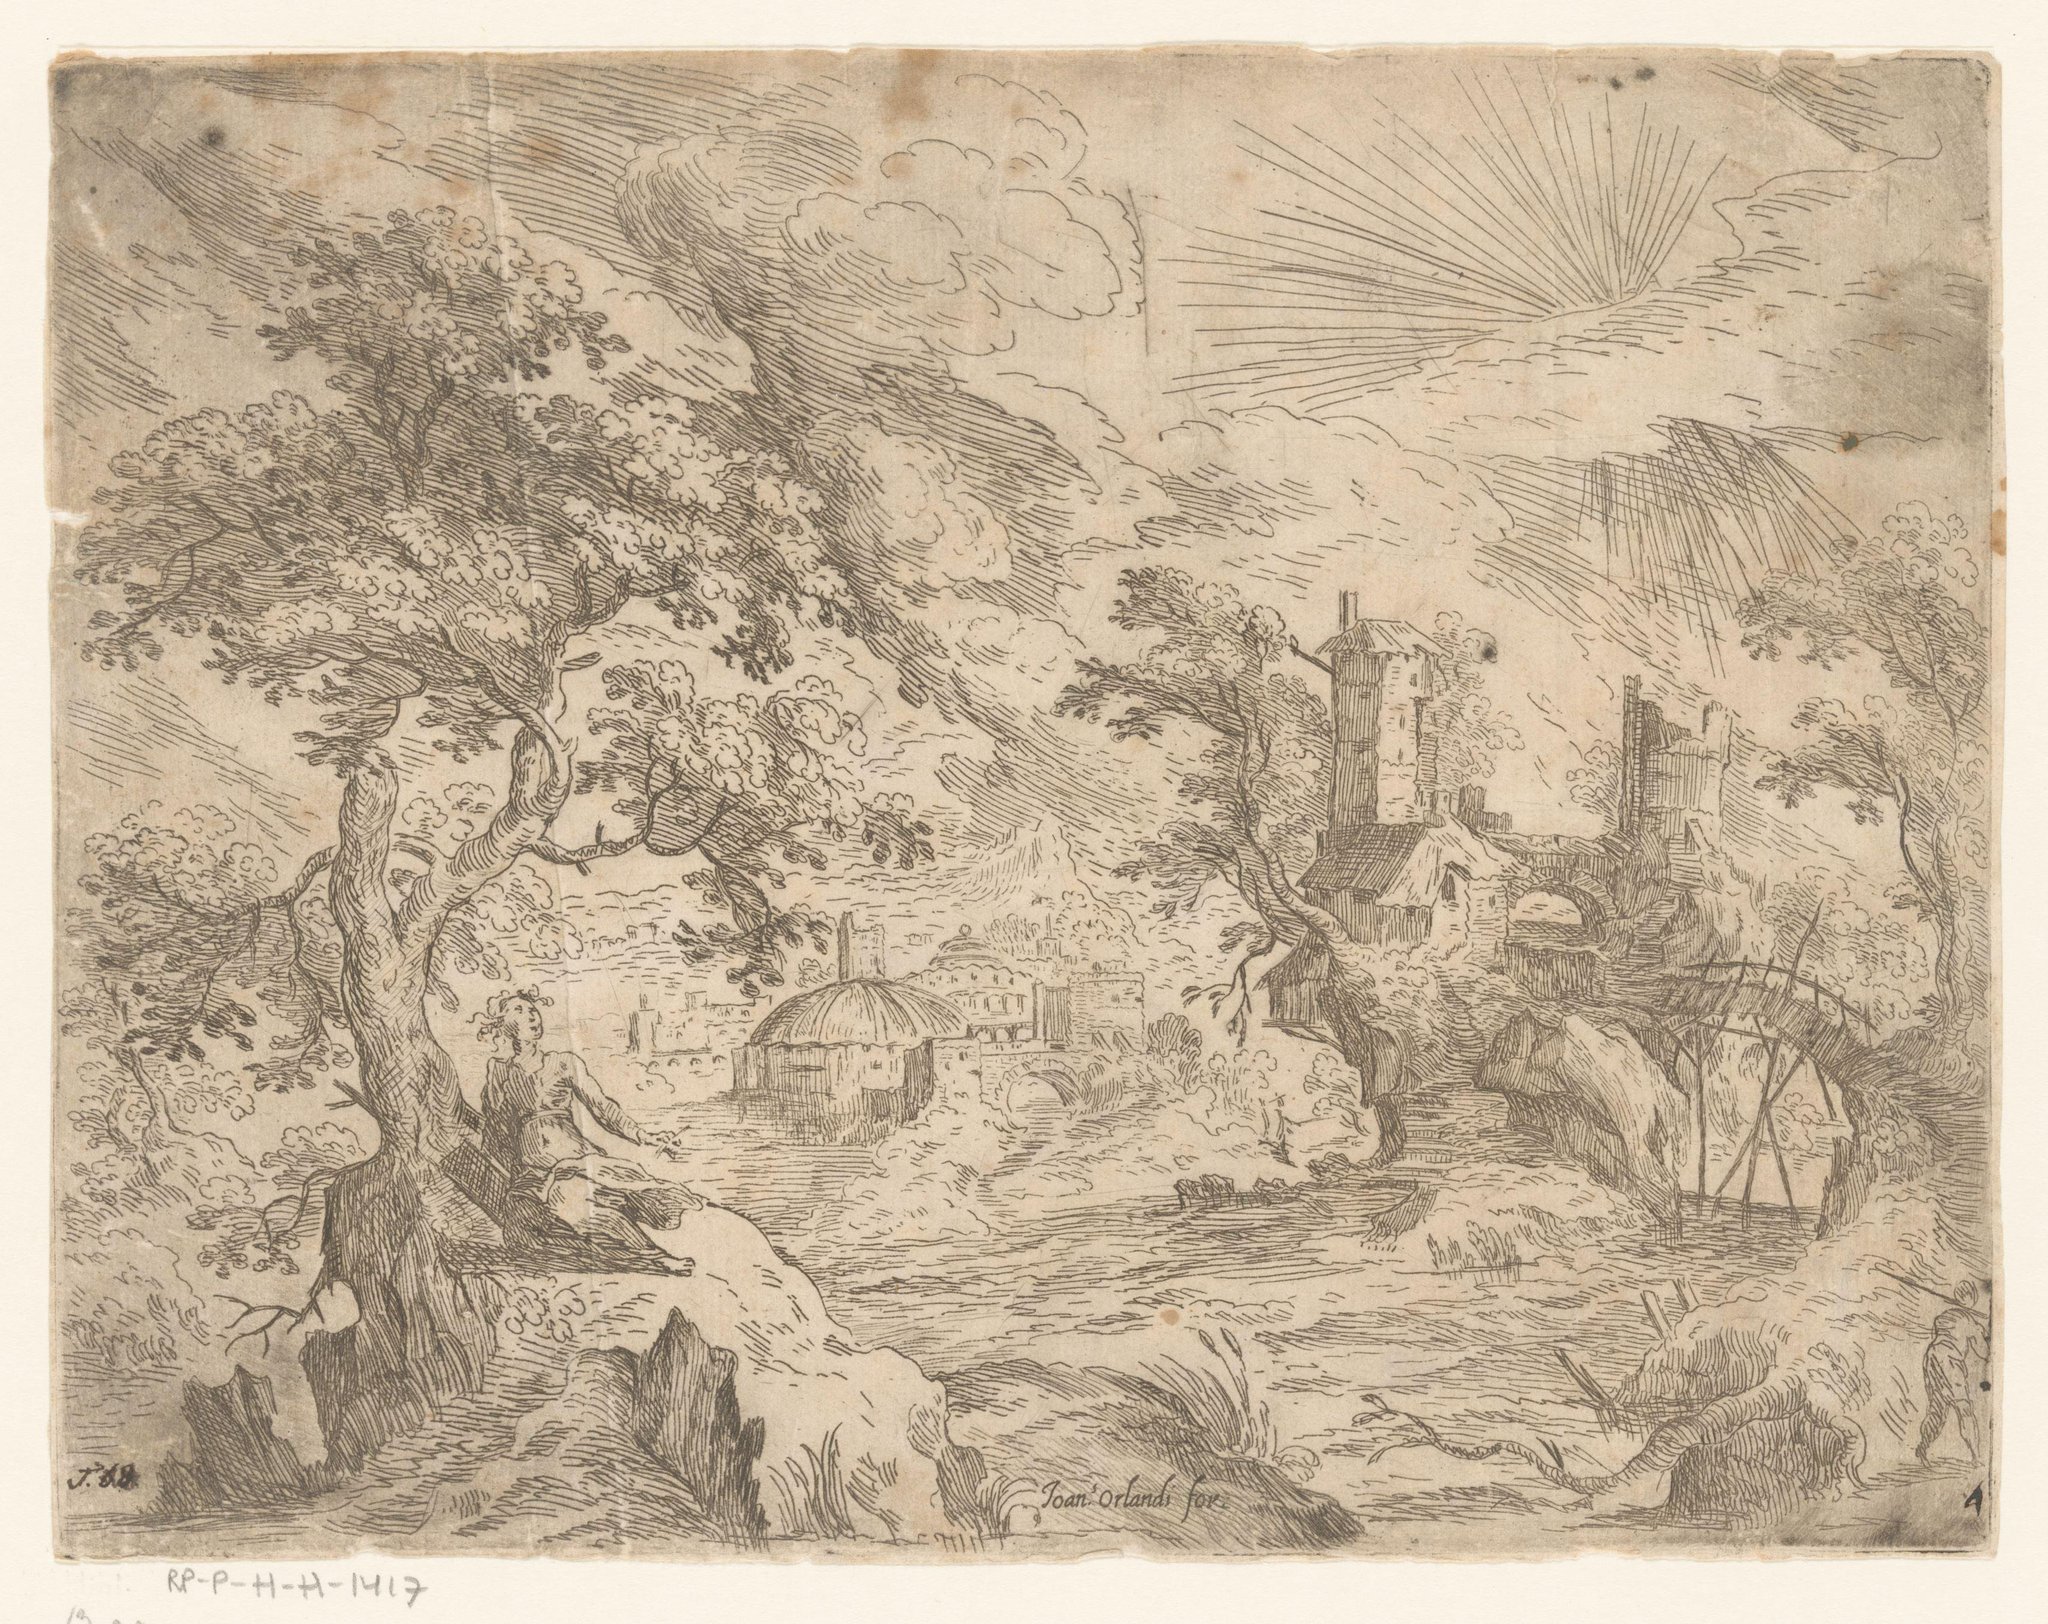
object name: print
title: Landschap met rivier en bouwsel op rots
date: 1590-1640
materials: paper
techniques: etching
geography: italy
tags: landscapes, river, landscape with ruins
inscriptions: number: ‘4’, collector's mark: Lugt 11, collector's mark: Lugt 2228, number: ‘T. 68.’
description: Landschap met rivier en een vervallen bouwsel op een rots. Op de voorgrond een vrouw onder een boom.